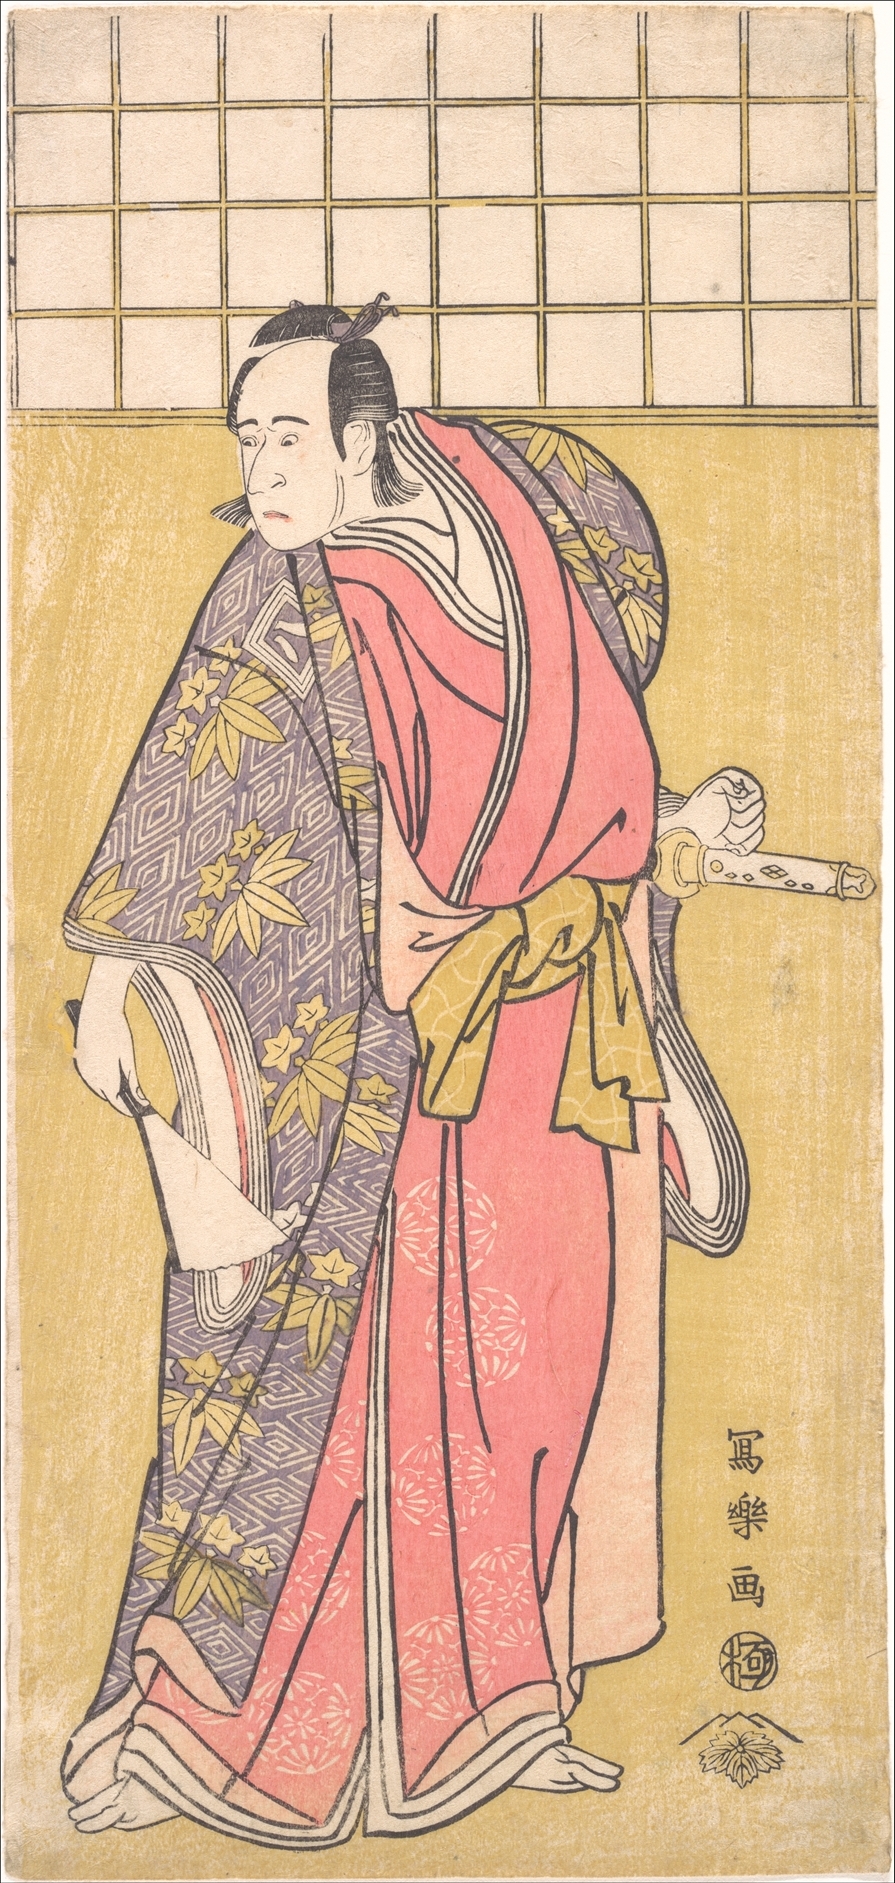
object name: print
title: The Actor Ichikawa Yaozō III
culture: japanese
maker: tōshūsai sharaku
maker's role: artist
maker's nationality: japanese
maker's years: 1794-1795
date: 1794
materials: ink, paper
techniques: woodblock print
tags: fans,men,actors